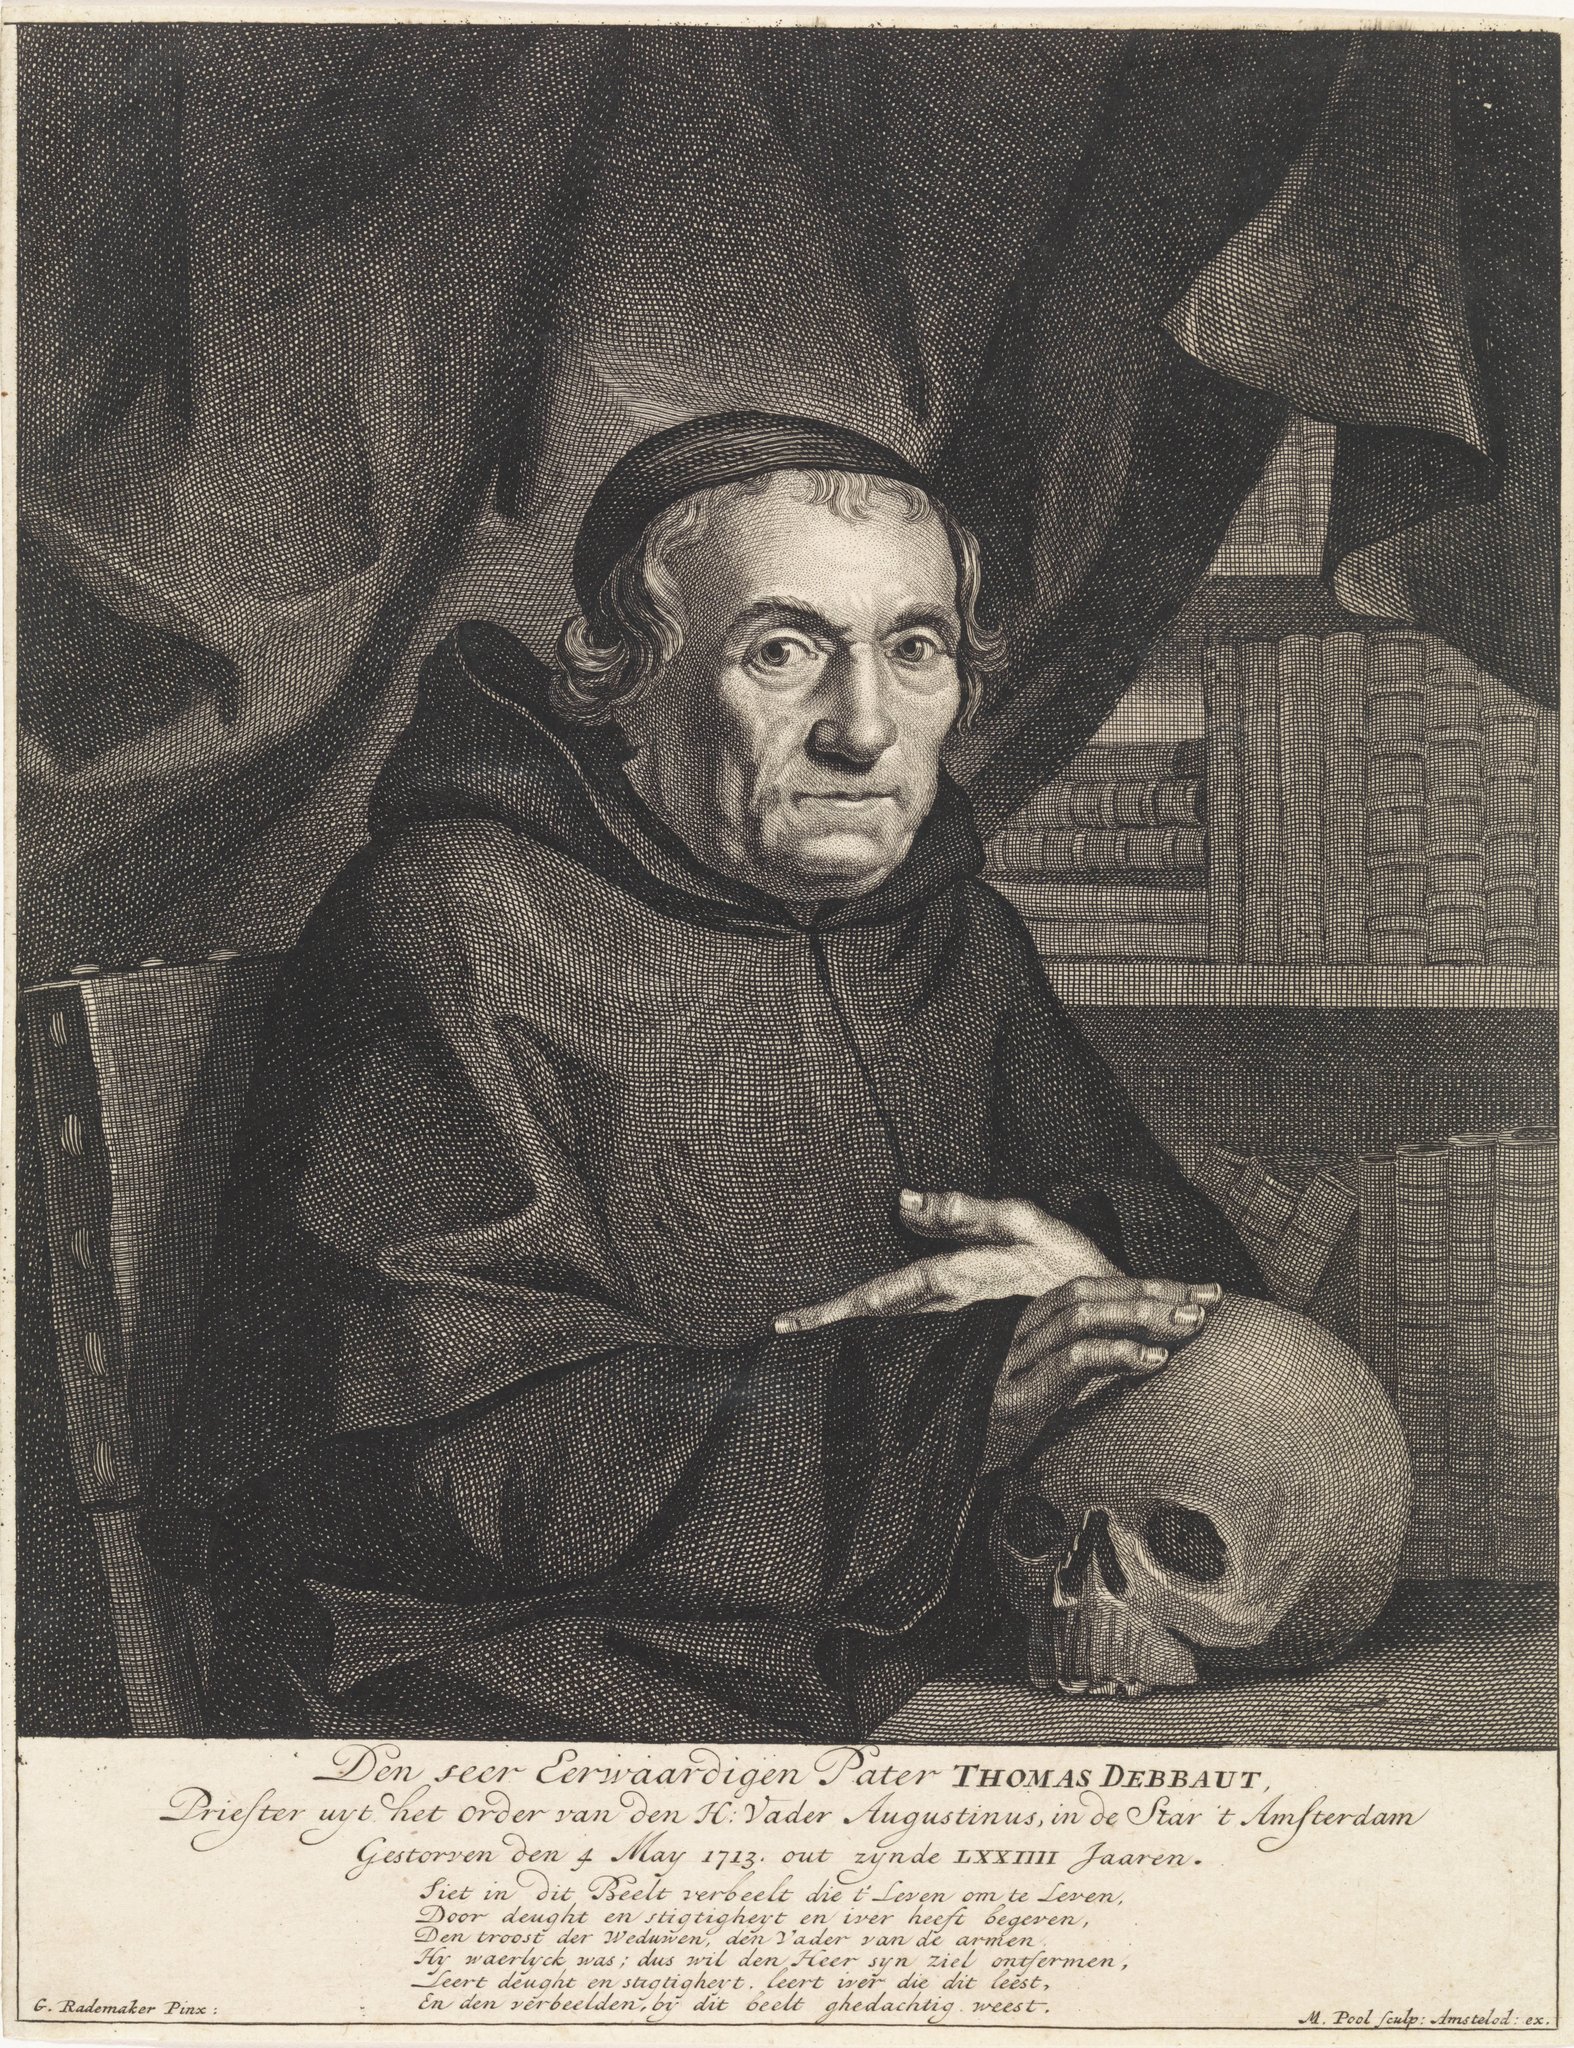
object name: print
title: Portret van de priester Thomas Debbaut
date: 1713-1727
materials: paper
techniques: engraving, etching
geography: amsterdam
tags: priest, book, skull as symbol of 'vanitas'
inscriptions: collector's mark: Lugt 2228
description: Portret van Thomas Debbaut, priester te Amsterdam, in een studeervertrek. Zijn rechterhand heeft hij op een doodshoofd gelegd. In de marge de naam van de geportretteerde en een zesregelig lofdicht in het Nederlands.